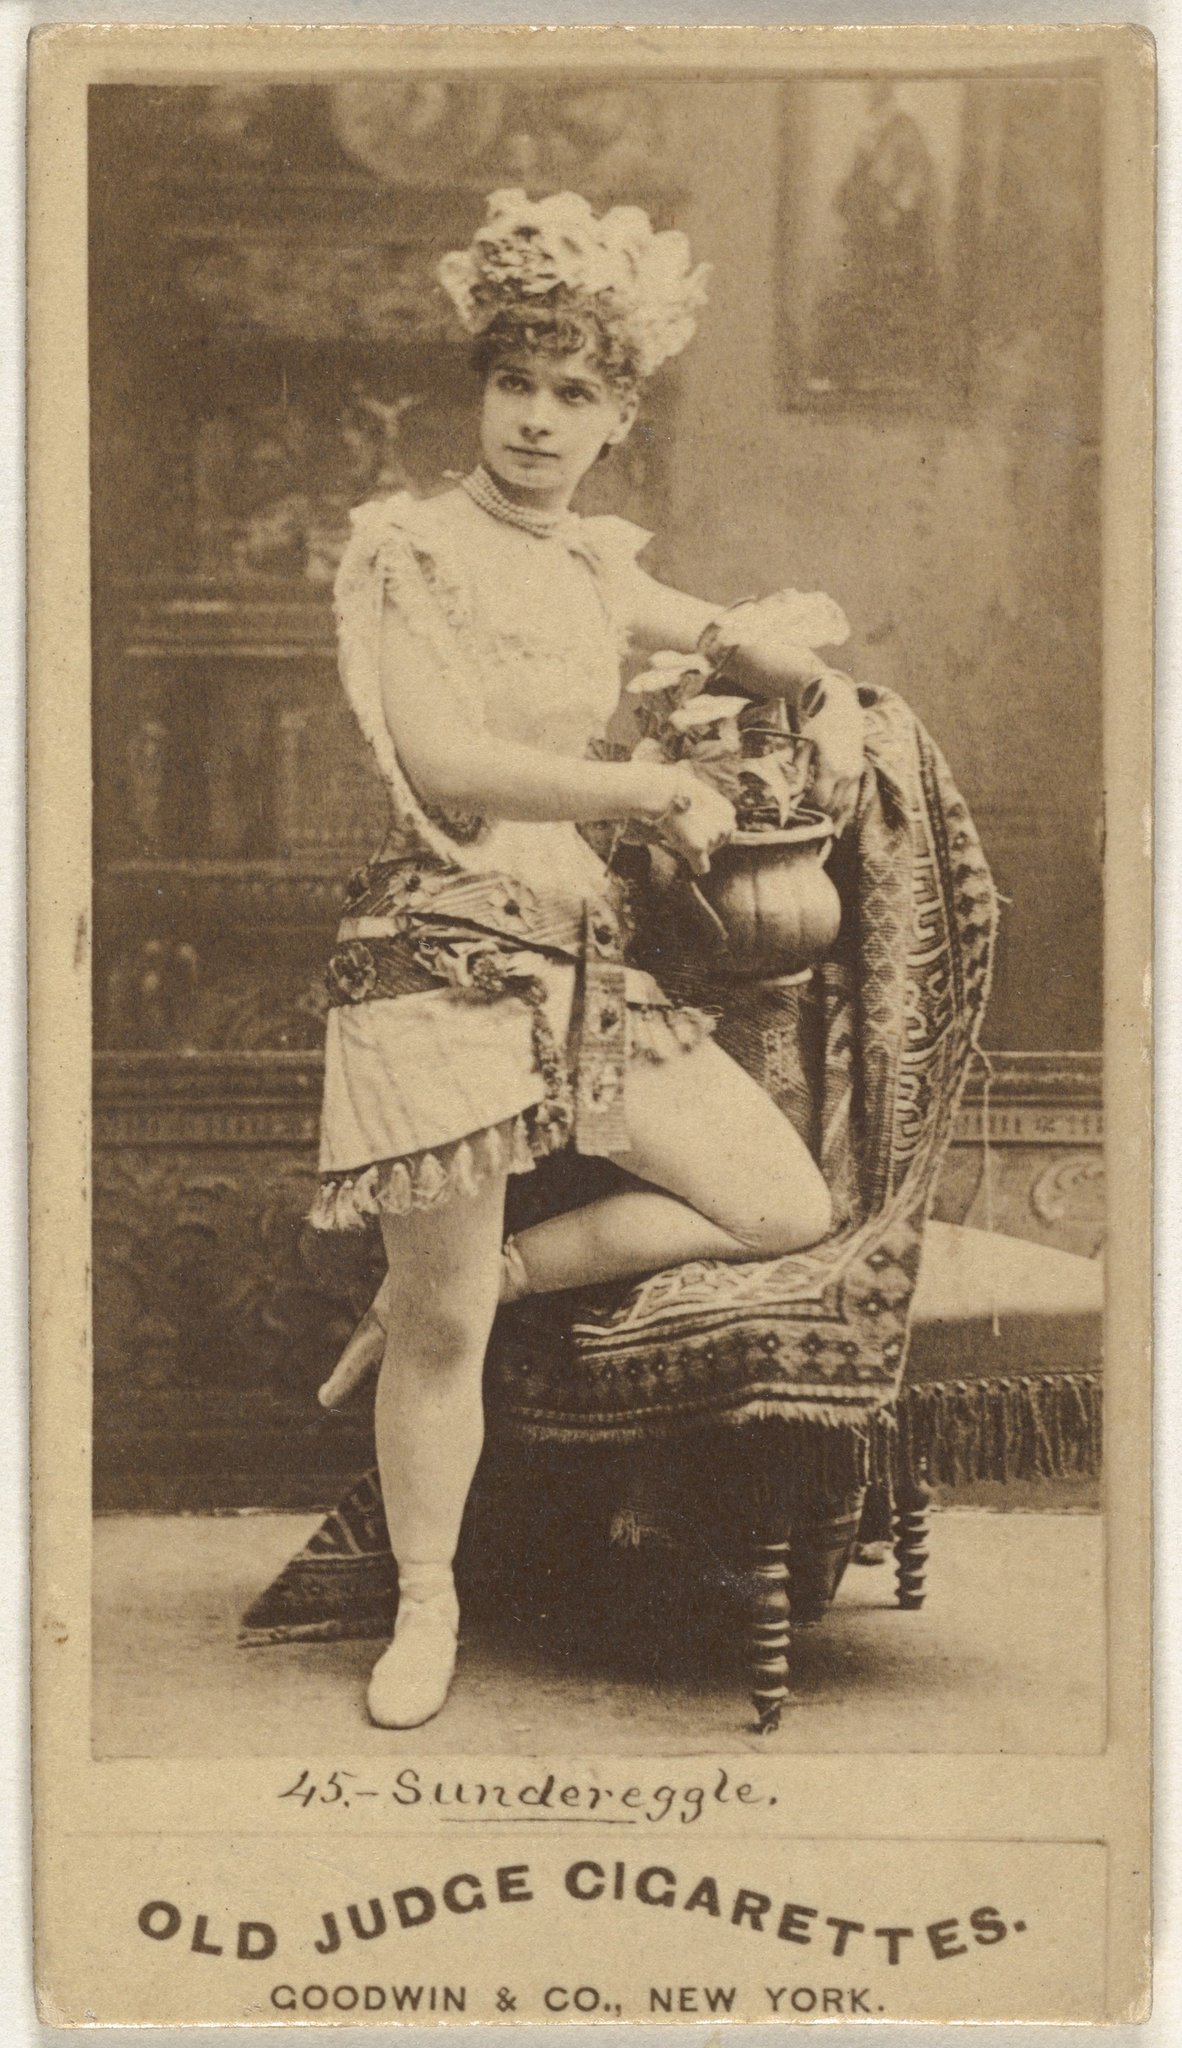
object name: photograph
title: Sundereggle, from the Actors and Actresses series (N171) for Old Judge Cigarettes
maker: goodwin & company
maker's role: publisher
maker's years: 1850-1950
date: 1886-1890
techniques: albumen silver print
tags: portraits,women,actresses